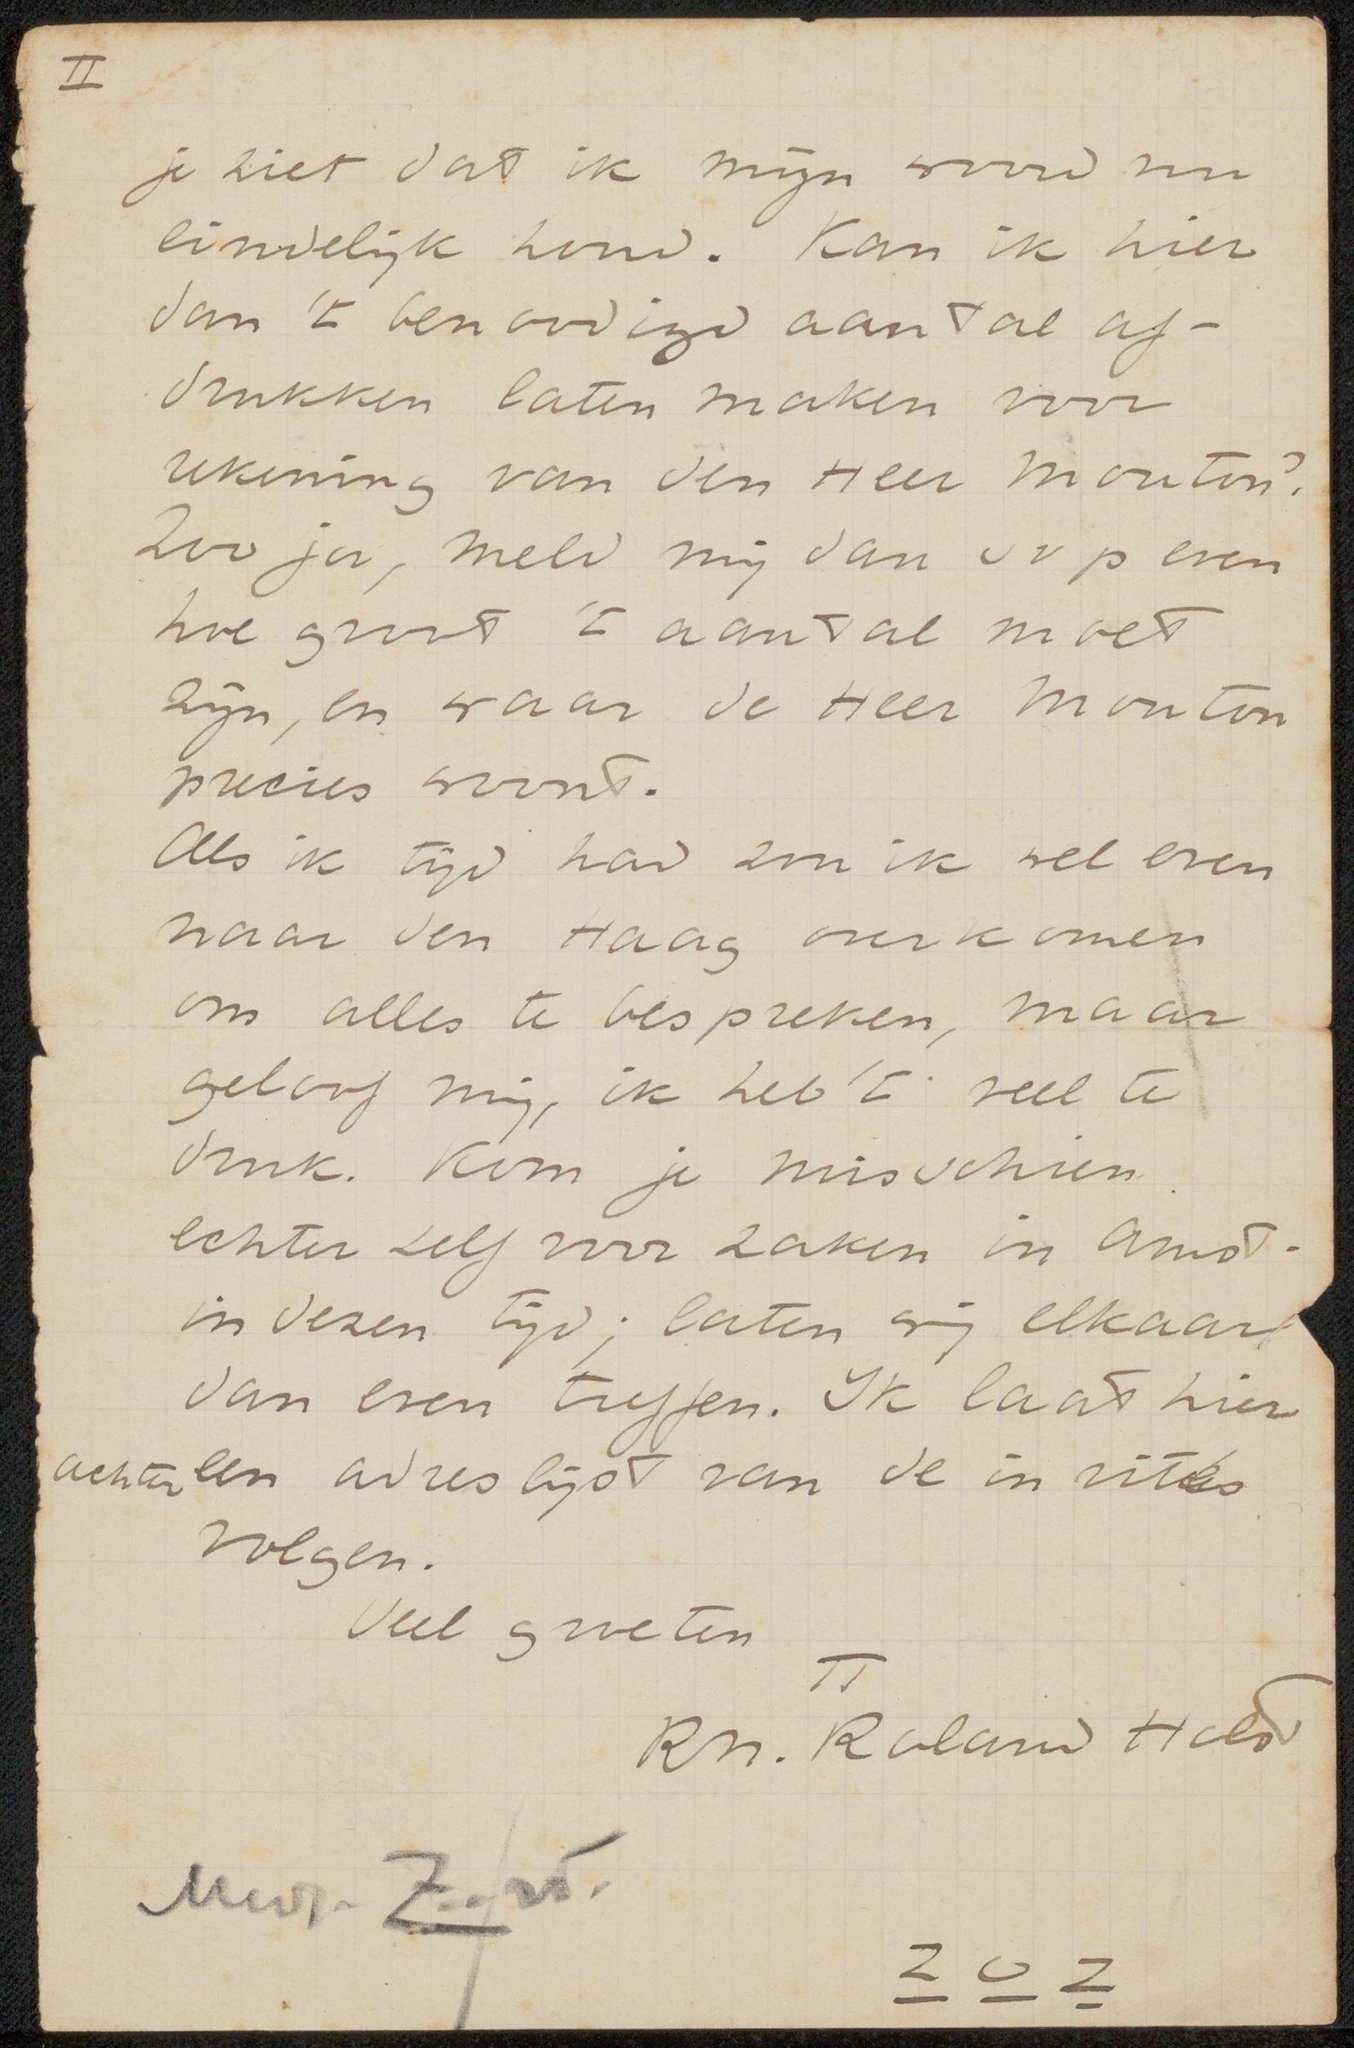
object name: letter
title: Brief aan Philip Zilcken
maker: richard nicolaüs roland holst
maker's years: 1868-1938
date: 1878-1930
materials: ink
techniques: pen, writing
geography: amsterdam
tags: london, print maker, charles ricketts, designer, william morris, charles haslewood shannon, walter crane, martinus mouton, paris, lucien pissarro, arthur gaskin, reginald savage, the hague, painter, philip zilcken, amsterdam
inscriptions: collector's mark: ‘RPK’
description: Vormt doorlopende brief met RP-D-1982-43-ROLAND-HOLST-2.